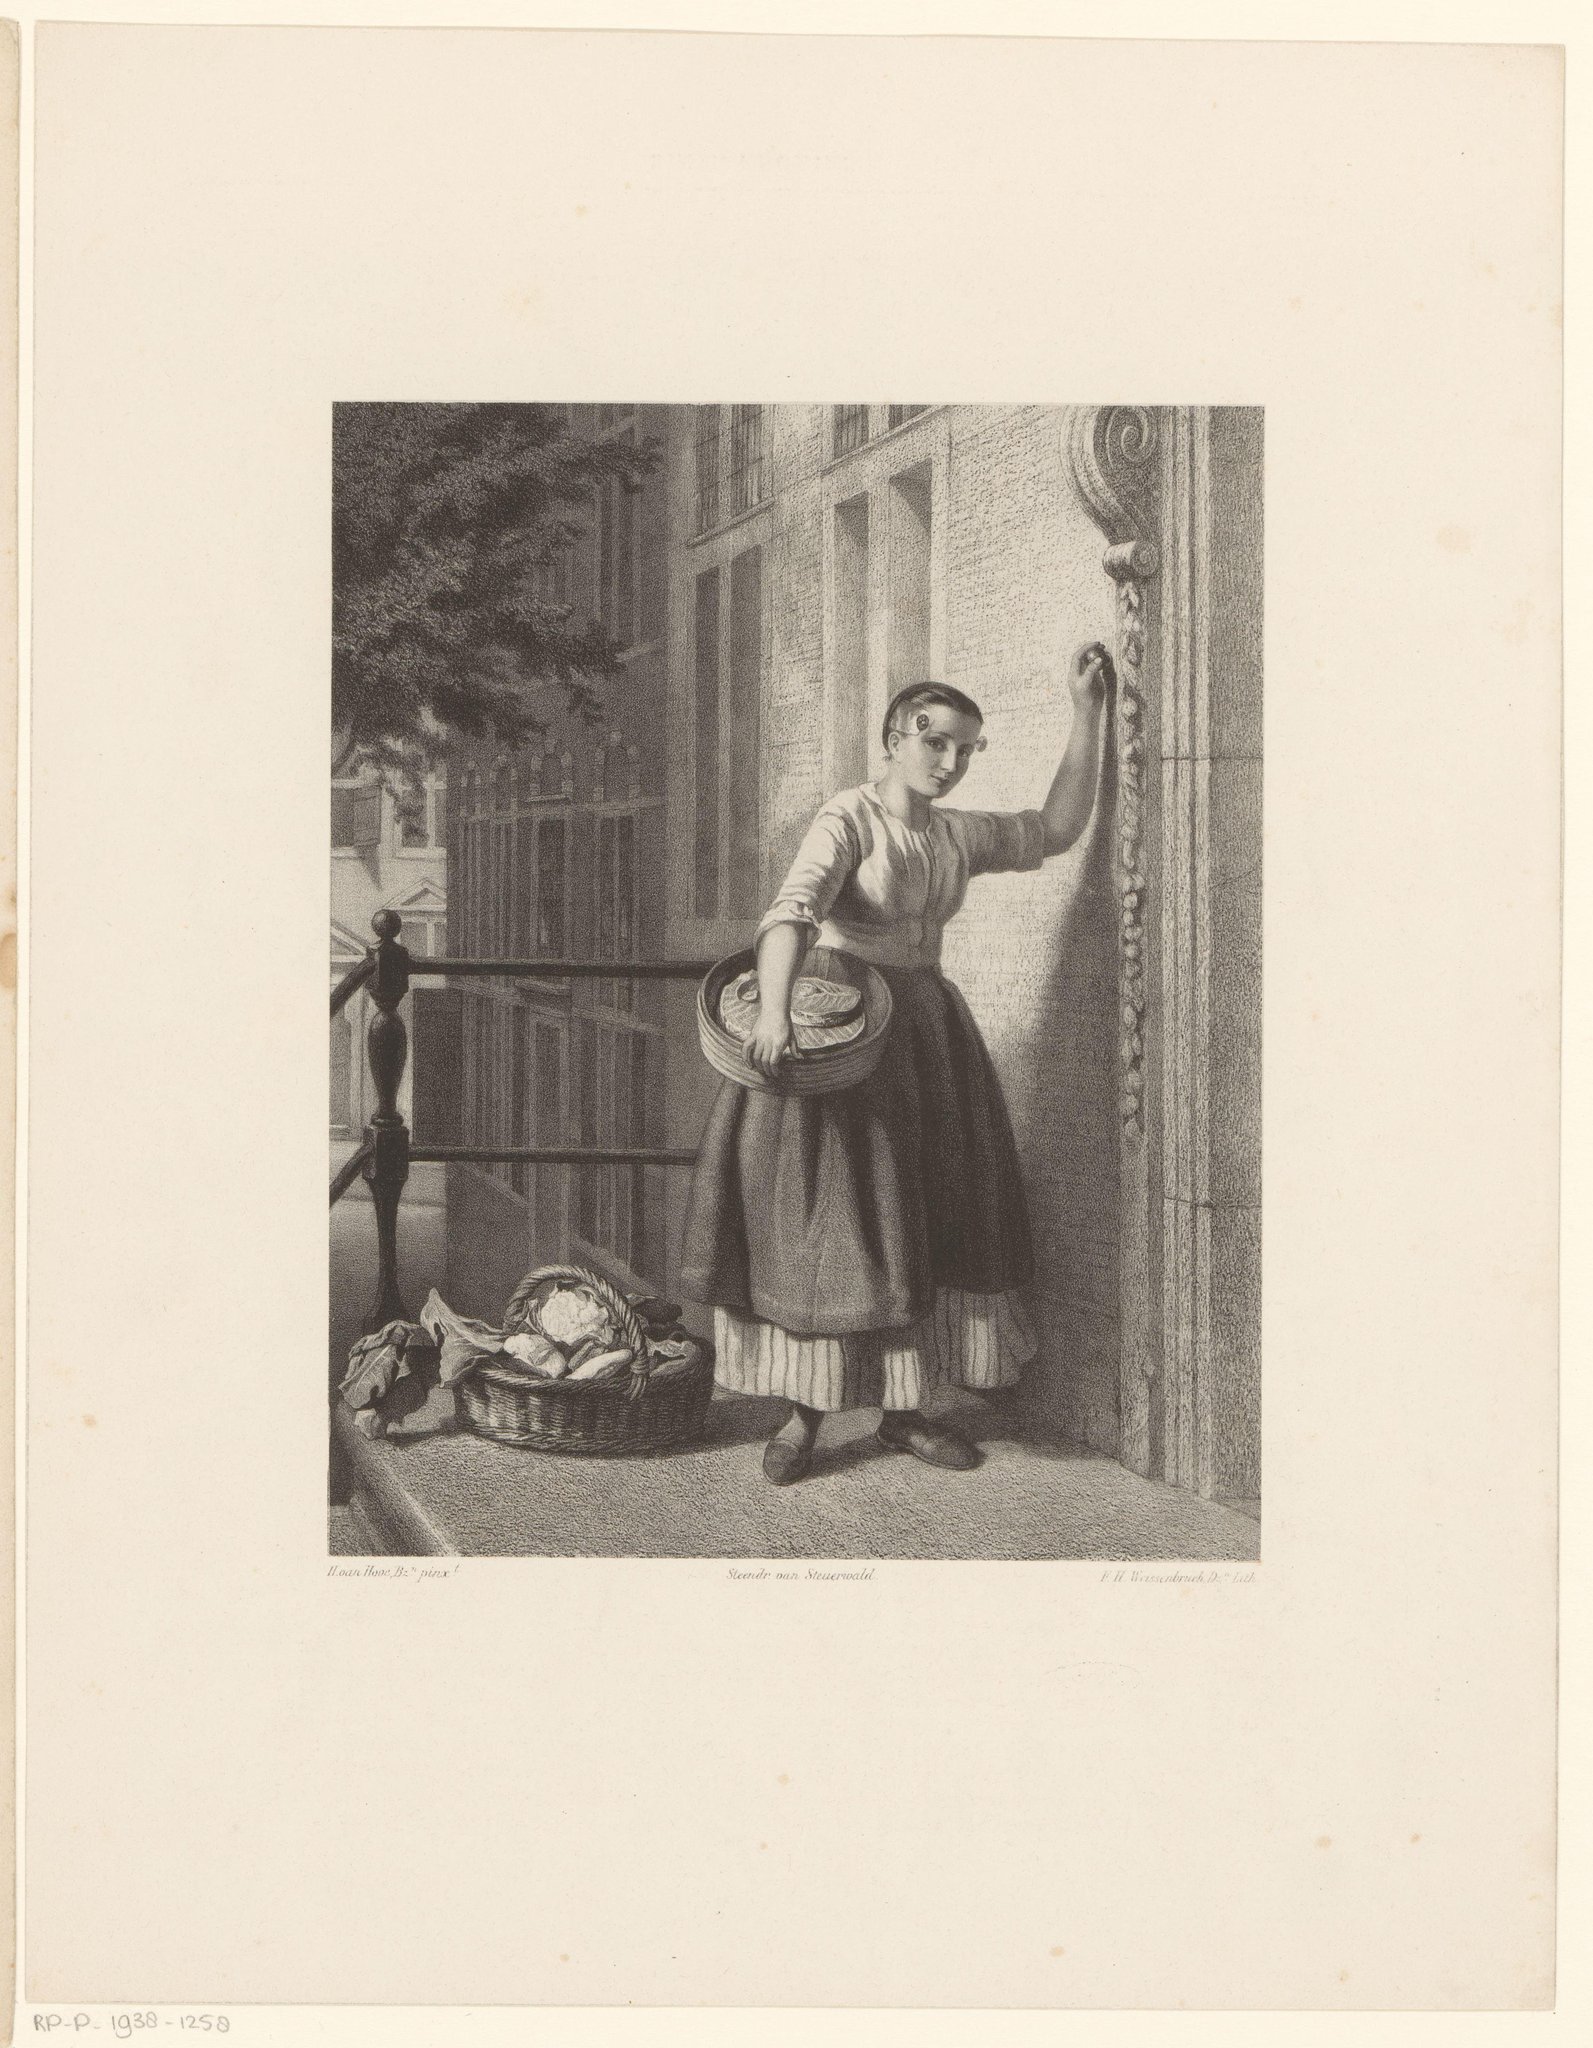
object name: print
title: Koopvrouw belt aan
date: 1838-1863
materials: paper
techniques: lithograph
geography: the hague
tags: vegetables, door-knocker, doorbell, street-trader - bb - women engaged in trade and commerce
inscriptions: collector's mark: Lugt 2228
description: Een jonge koopvrouw met een mand onder haar arm staat voor een portaal en belt aan. Naast haar staat een mand met groente.